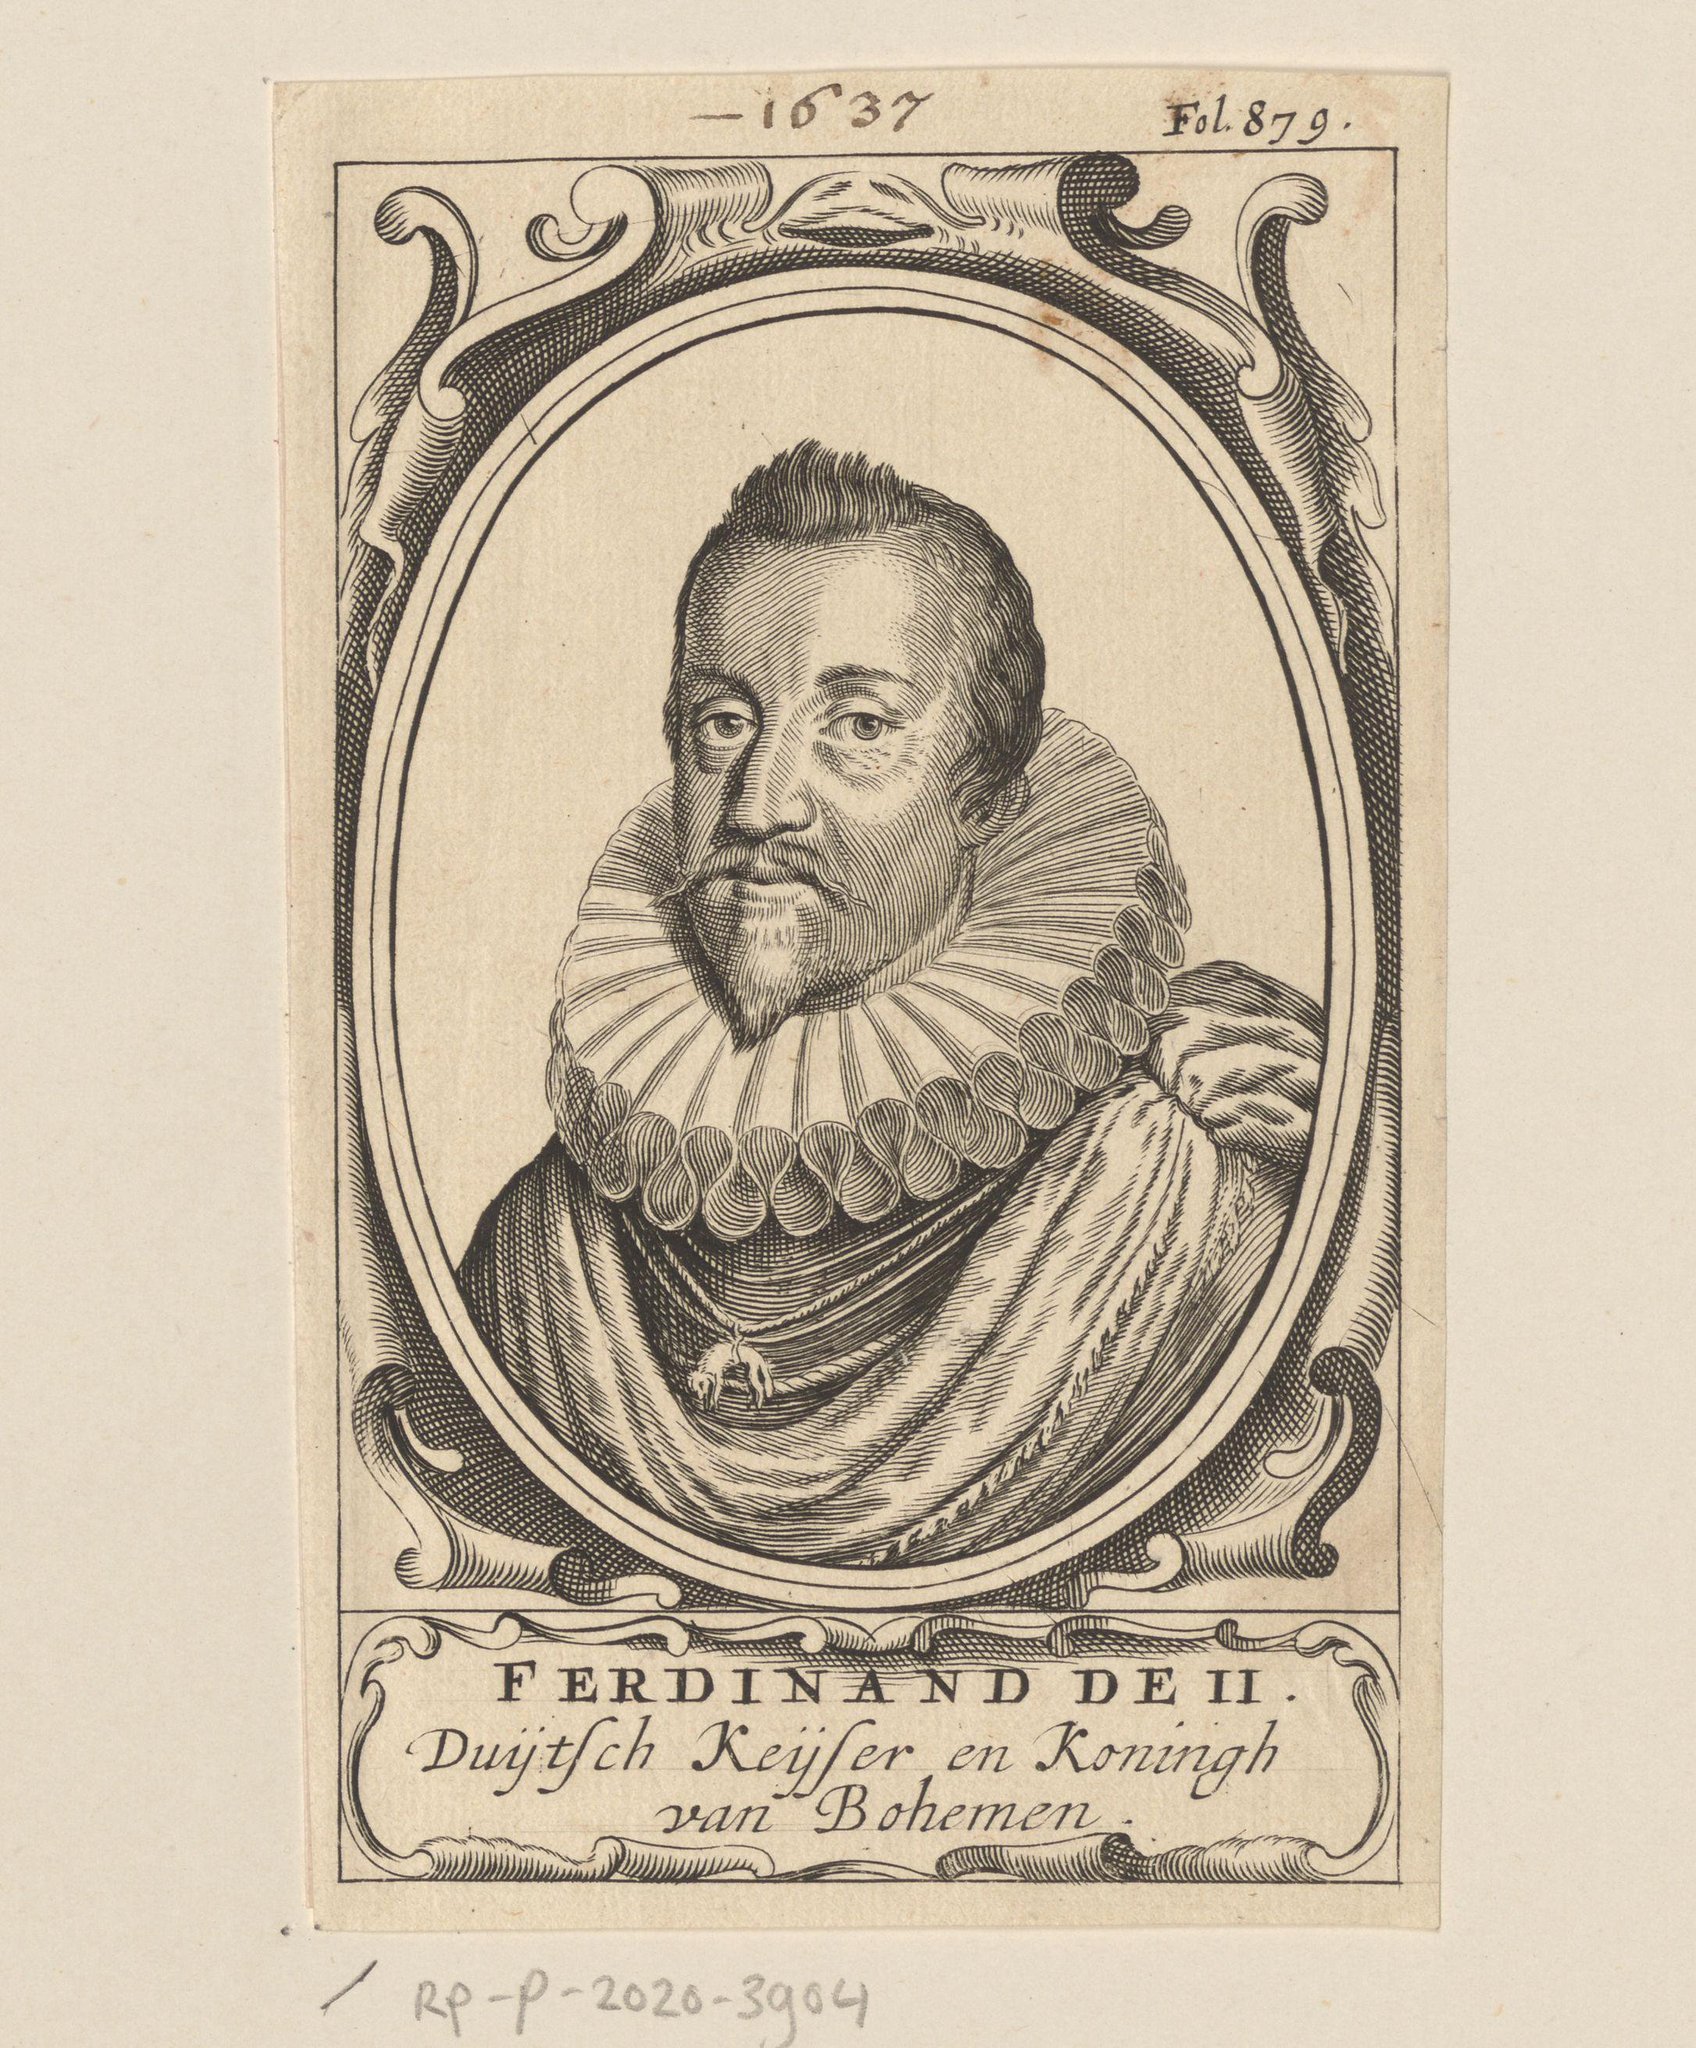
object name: book illustration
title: Portret van keizer Ferdinand II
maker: Anonymous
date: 1669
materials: paper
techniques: engraving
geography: northern netherlands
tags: vienna, ferdinand ii (duits keizer), historical persons, knighthood order of the golden fleece, emperor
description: Prent waarschijnlijk uit: Corput, Abraham van den. De goddelicke vierschare, dat is ontdeckinge der hemelsche oordelen (…). Utrecht: Johannes Janssonius van Waesberge I, 1669, dl. 4. Prent mogelijk ook gebruikt in latere edities van dit werk.